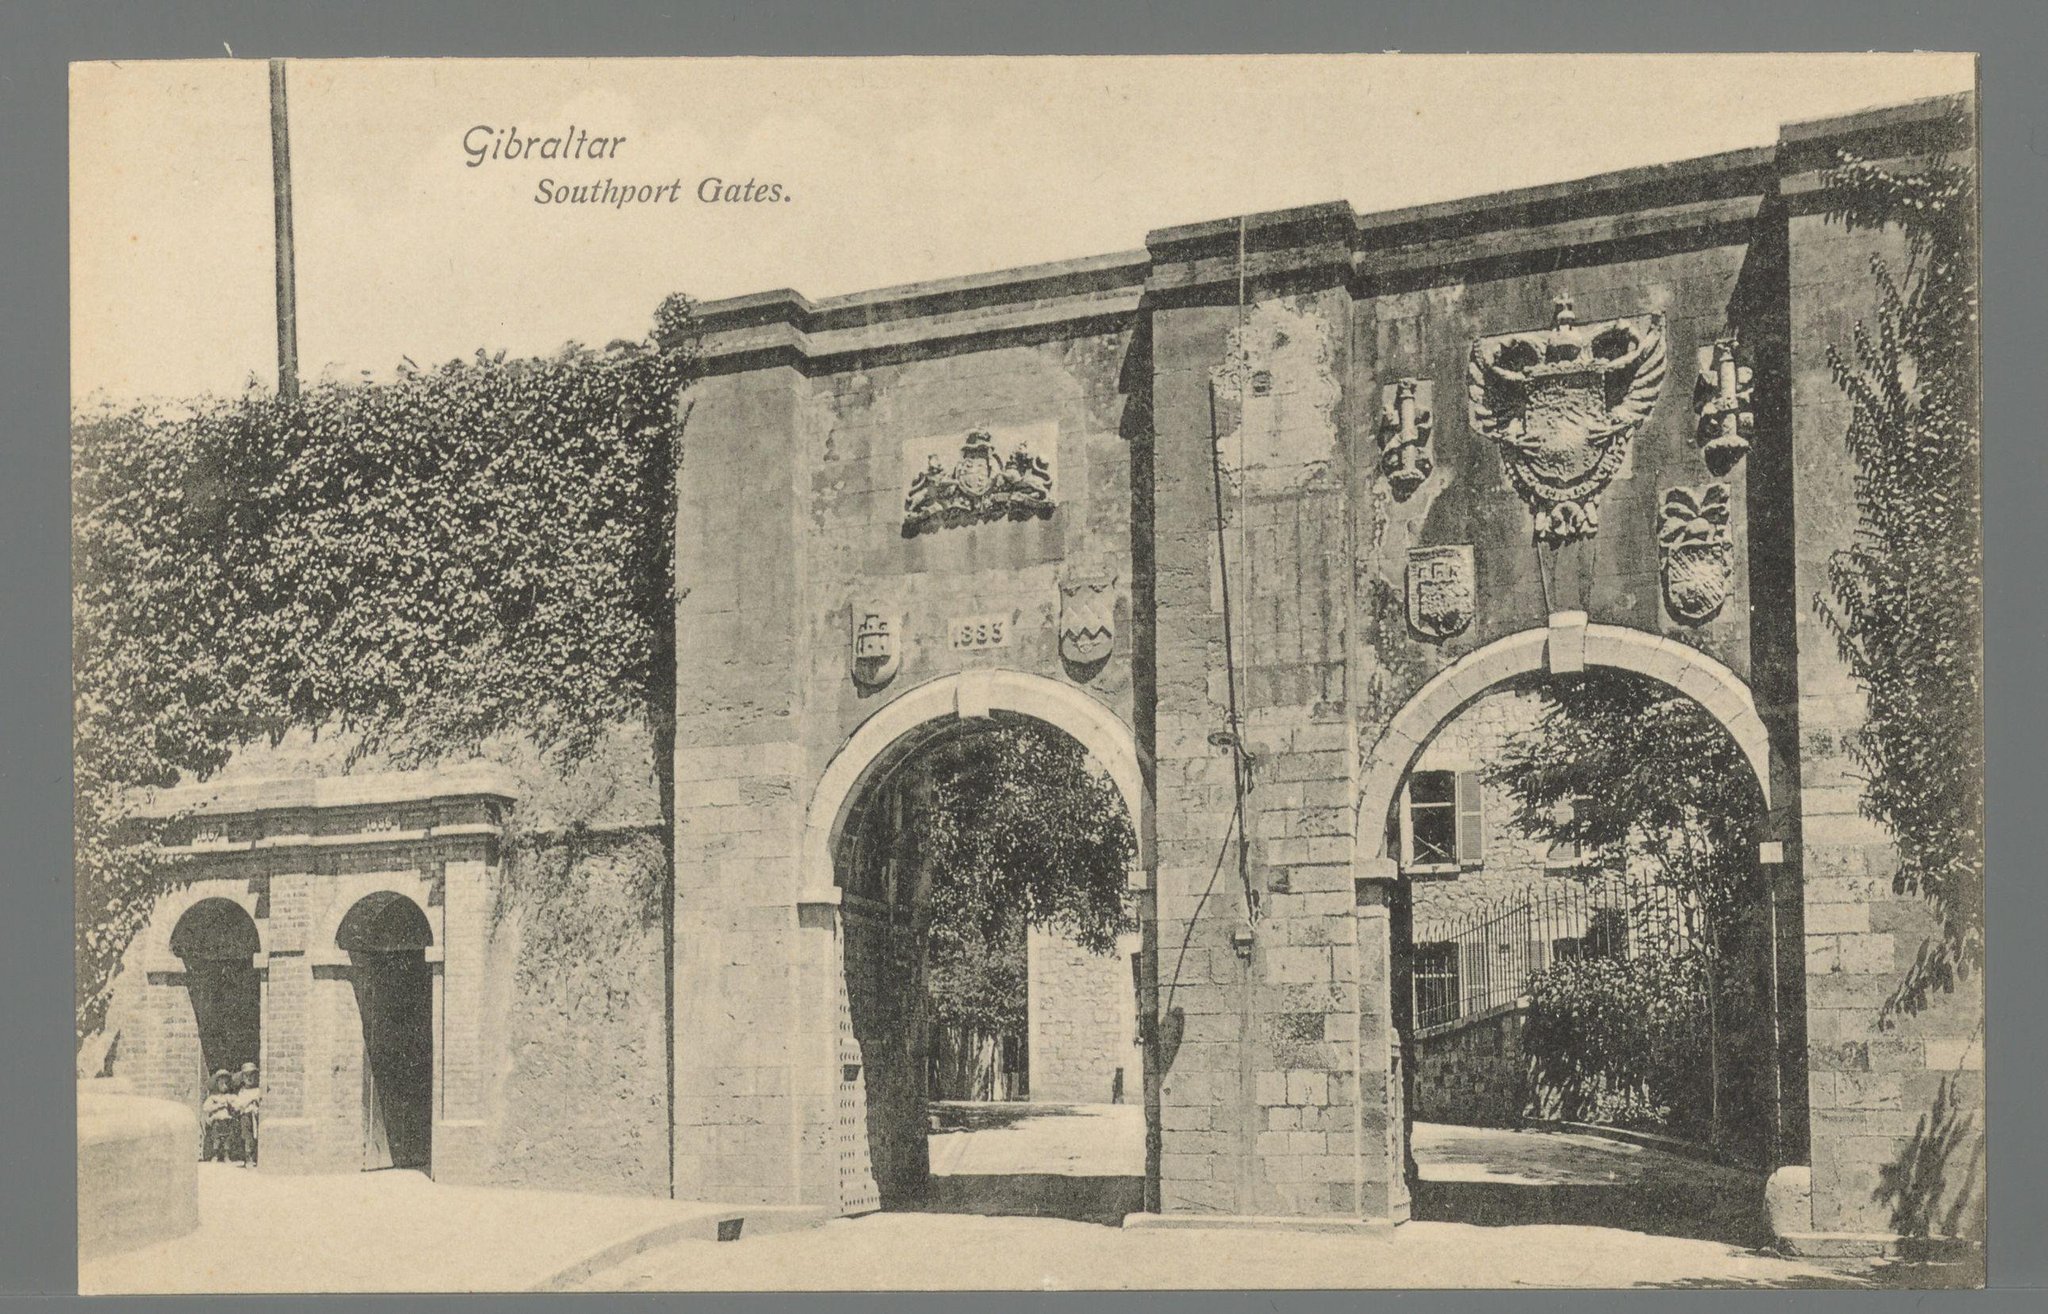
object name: photomechanical print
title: Gibraltar. Southport Gates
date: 1906-1930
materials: cardboard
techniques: photograph, writing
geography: gibraltar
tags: city-gate